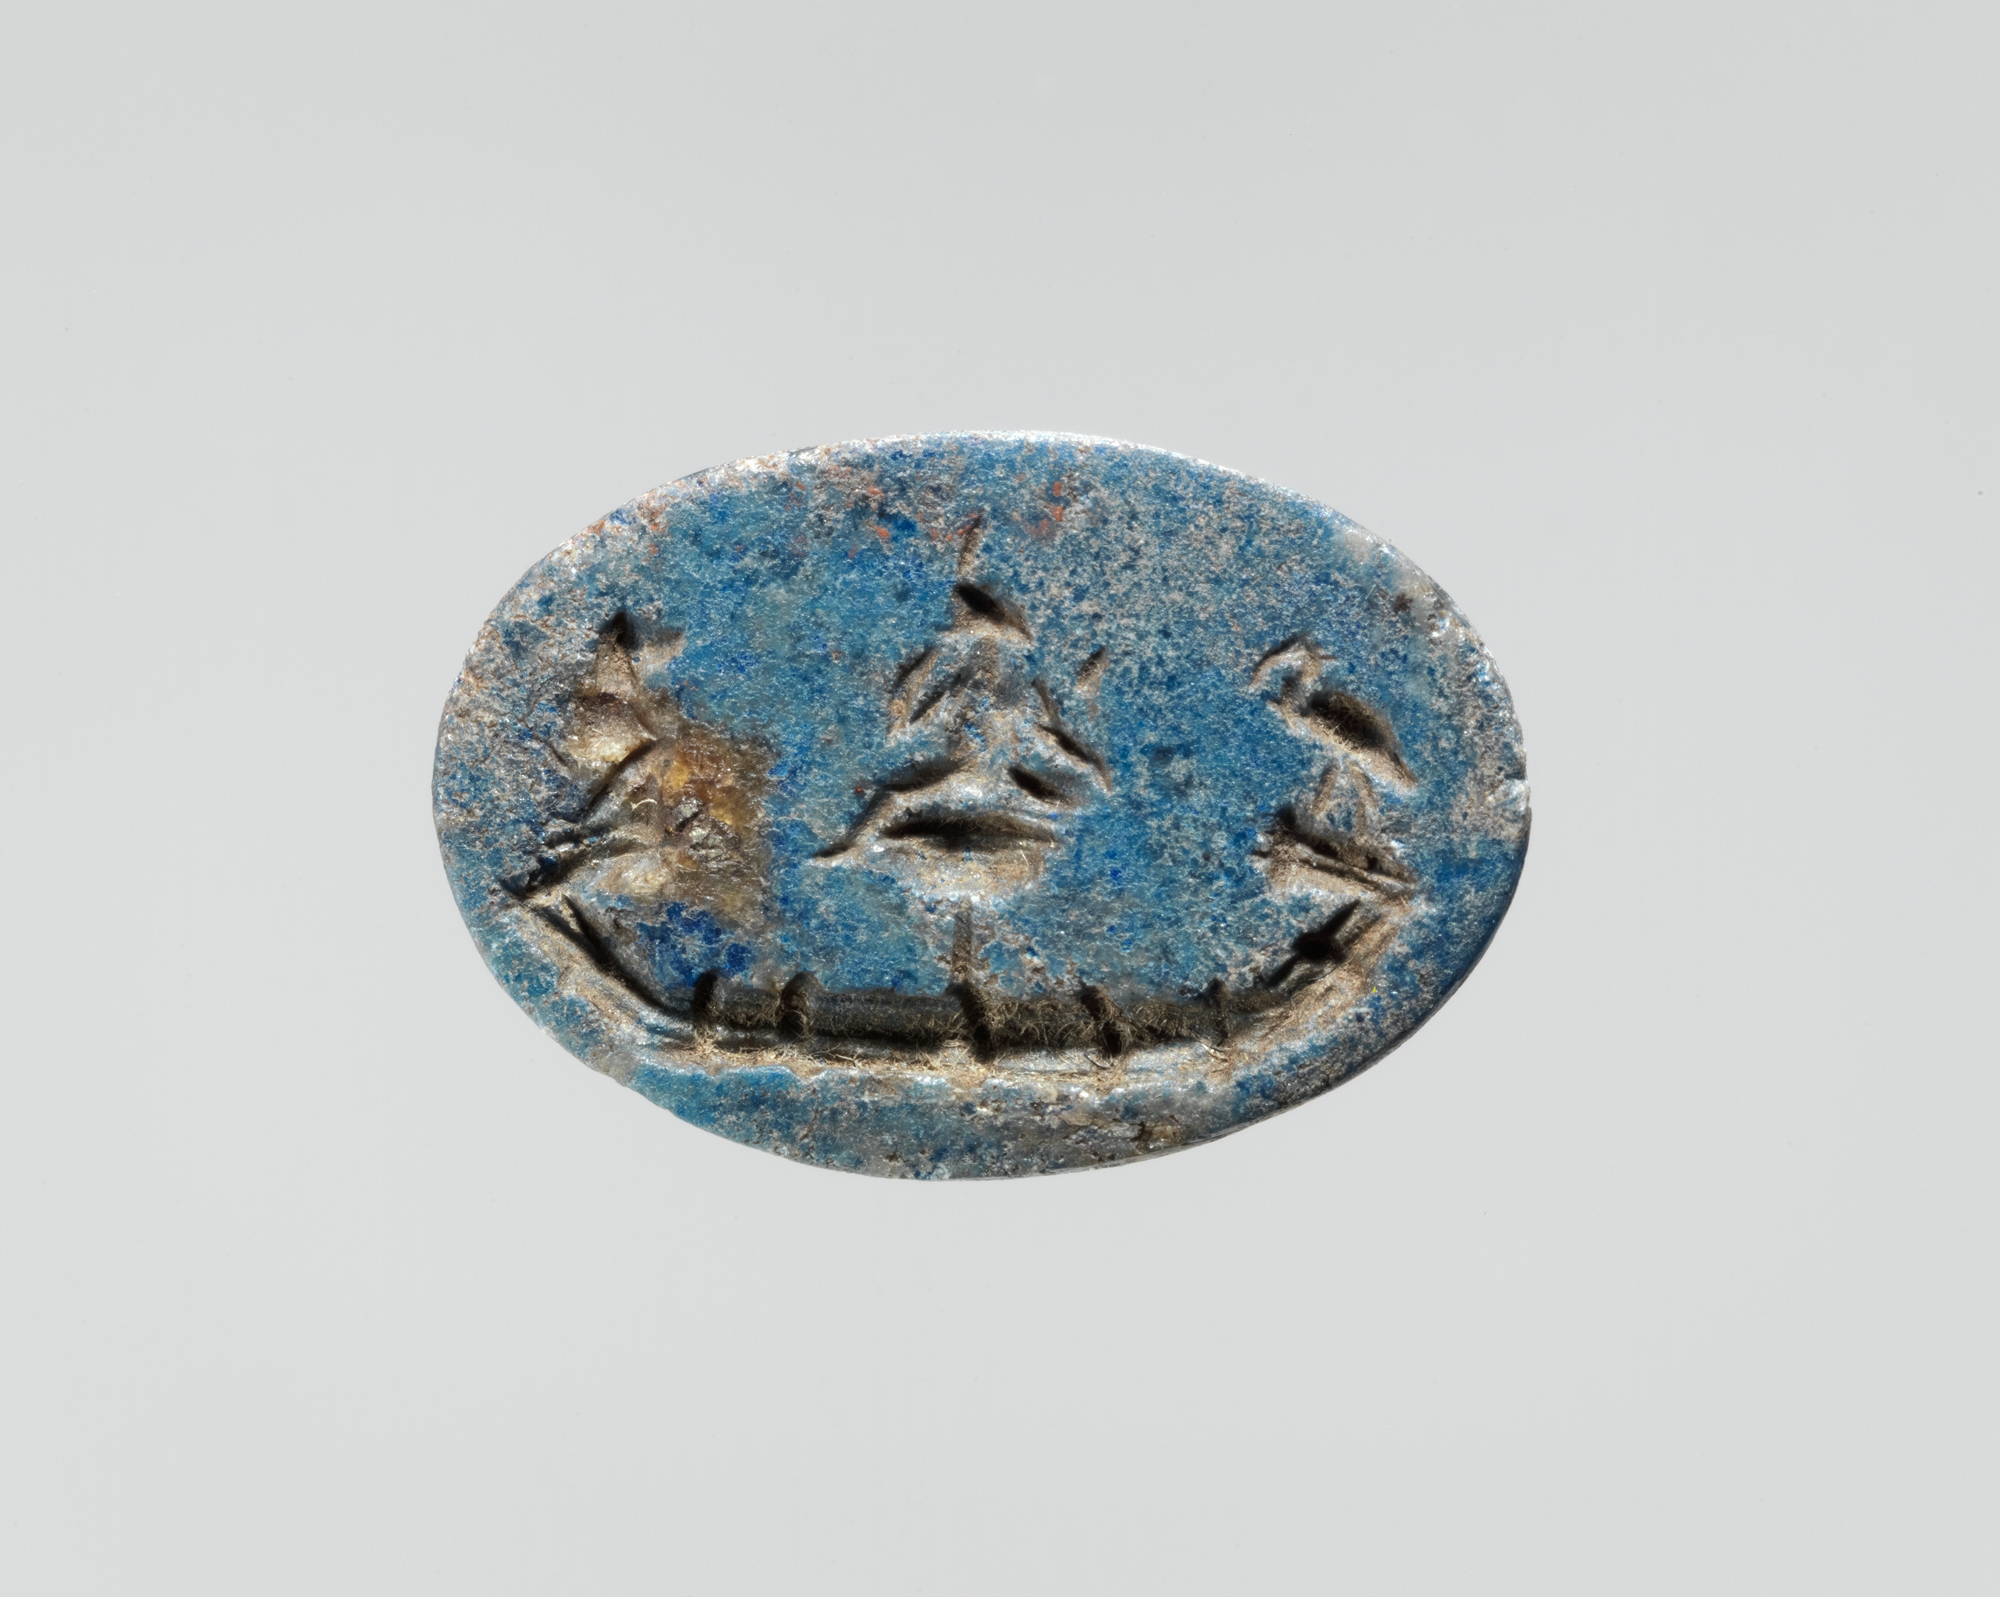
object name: intaglio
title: Lapis lazuli intaglio: Harpocrates in a papyrus boat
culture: roman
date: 101-200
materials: lapis lazuli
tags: birds,boats